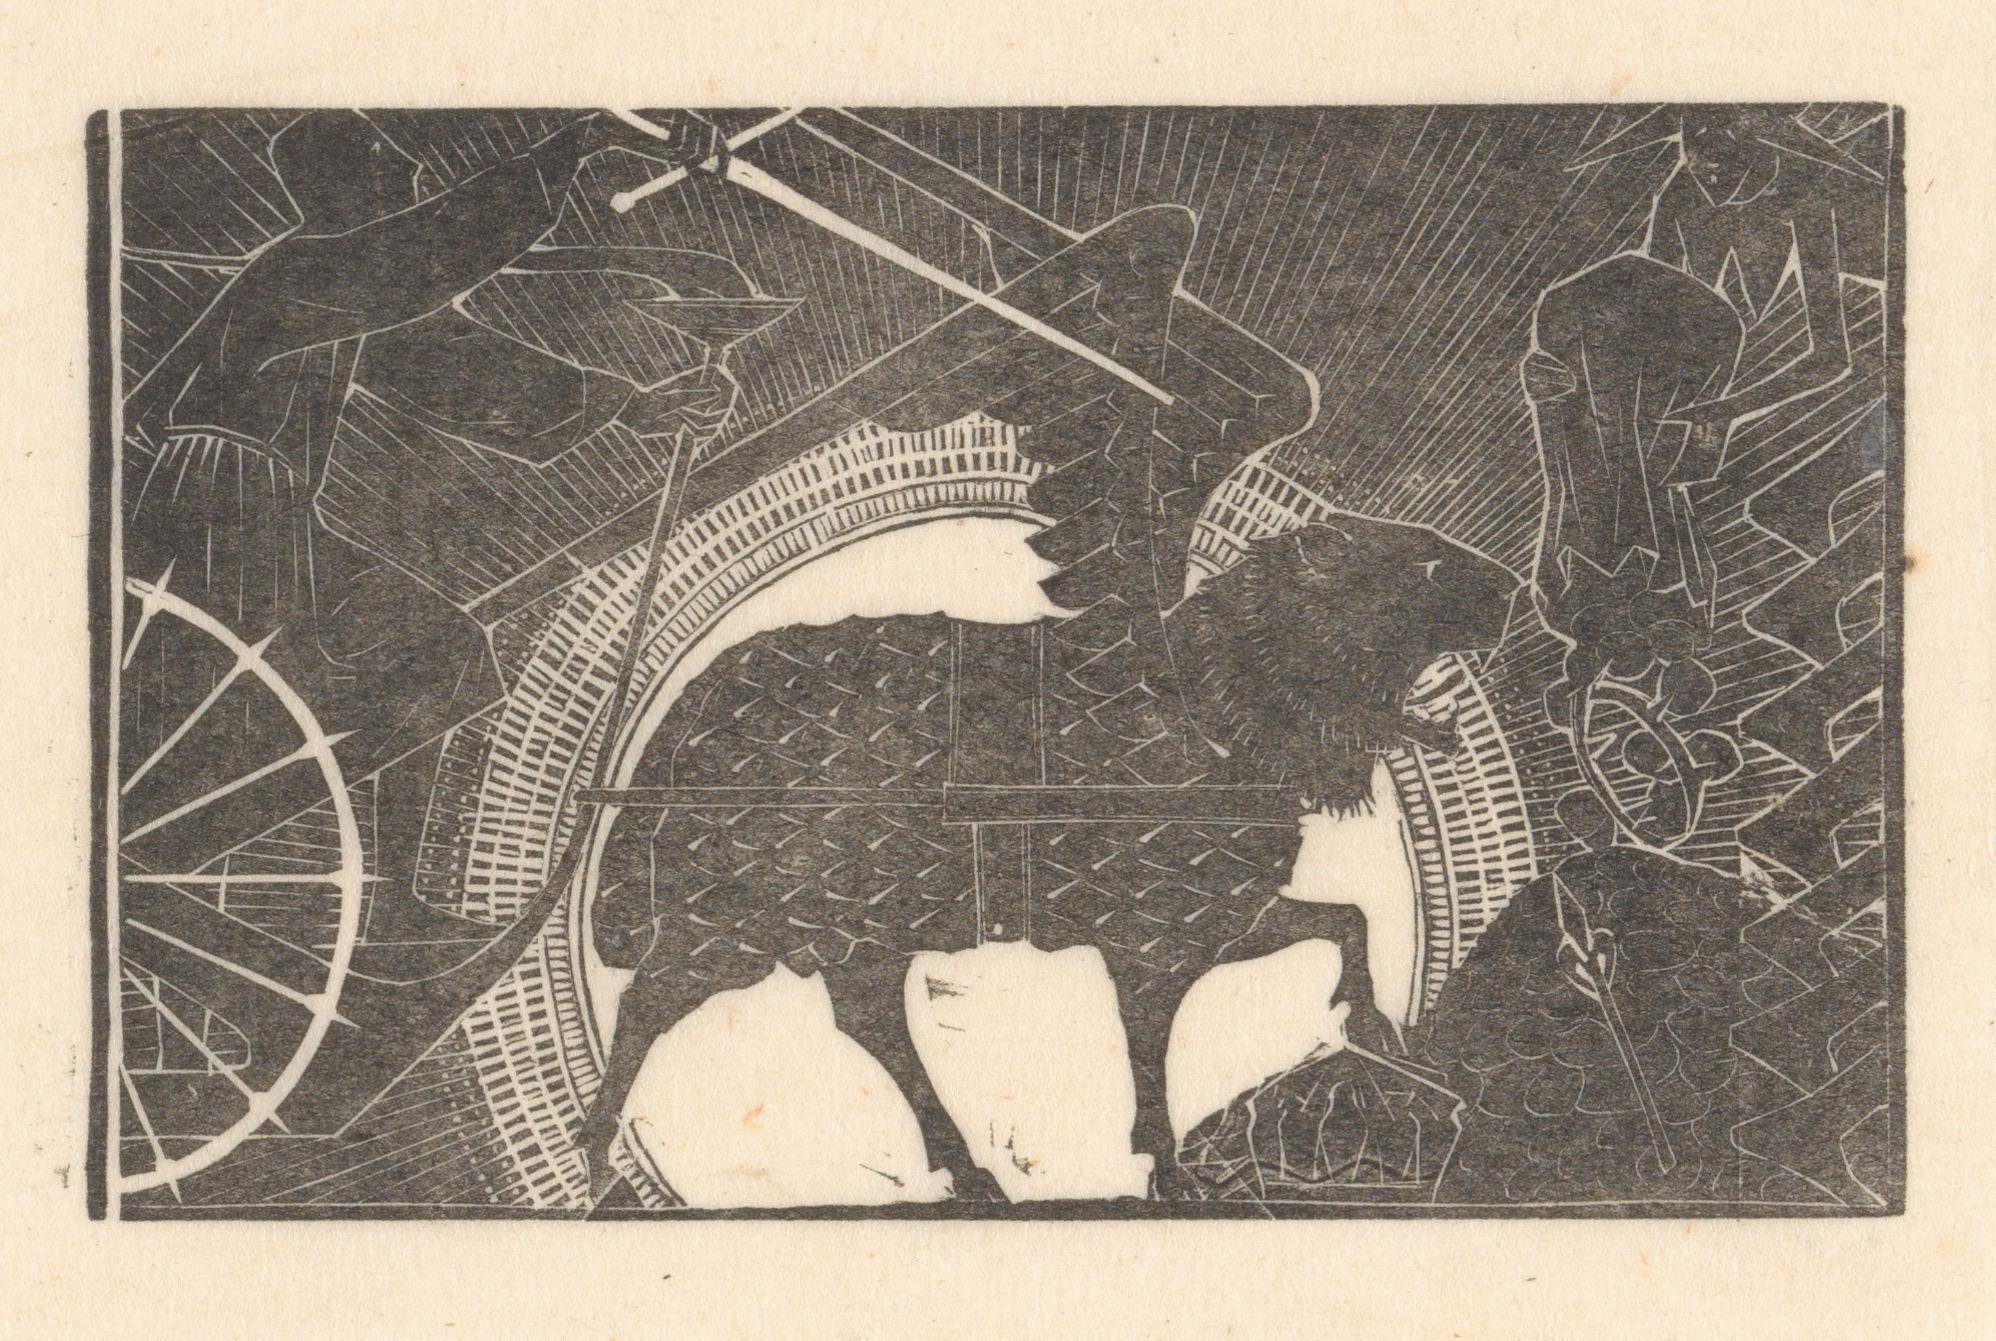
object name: print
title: Twaalf houtsneden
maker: mathieu lauweriks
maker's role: designer, draughtsman, print maker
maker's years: 1864-1932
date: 1895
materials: paper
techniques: woodcut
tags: chimera (lion/goat/snake); 'chimera' (ripa), (farm) wagon, freight wagon, cart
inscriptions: collector's mark: Lugt 2228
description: Een Chimaera, een gevleugelde leeuw met schapenpoten, trekt een wagen met gepunte wielen. Op de wagen zit een man met een zwaard. Rechts worden schatten uitgestrooid. Op de achtergrond de ondergaande zon.